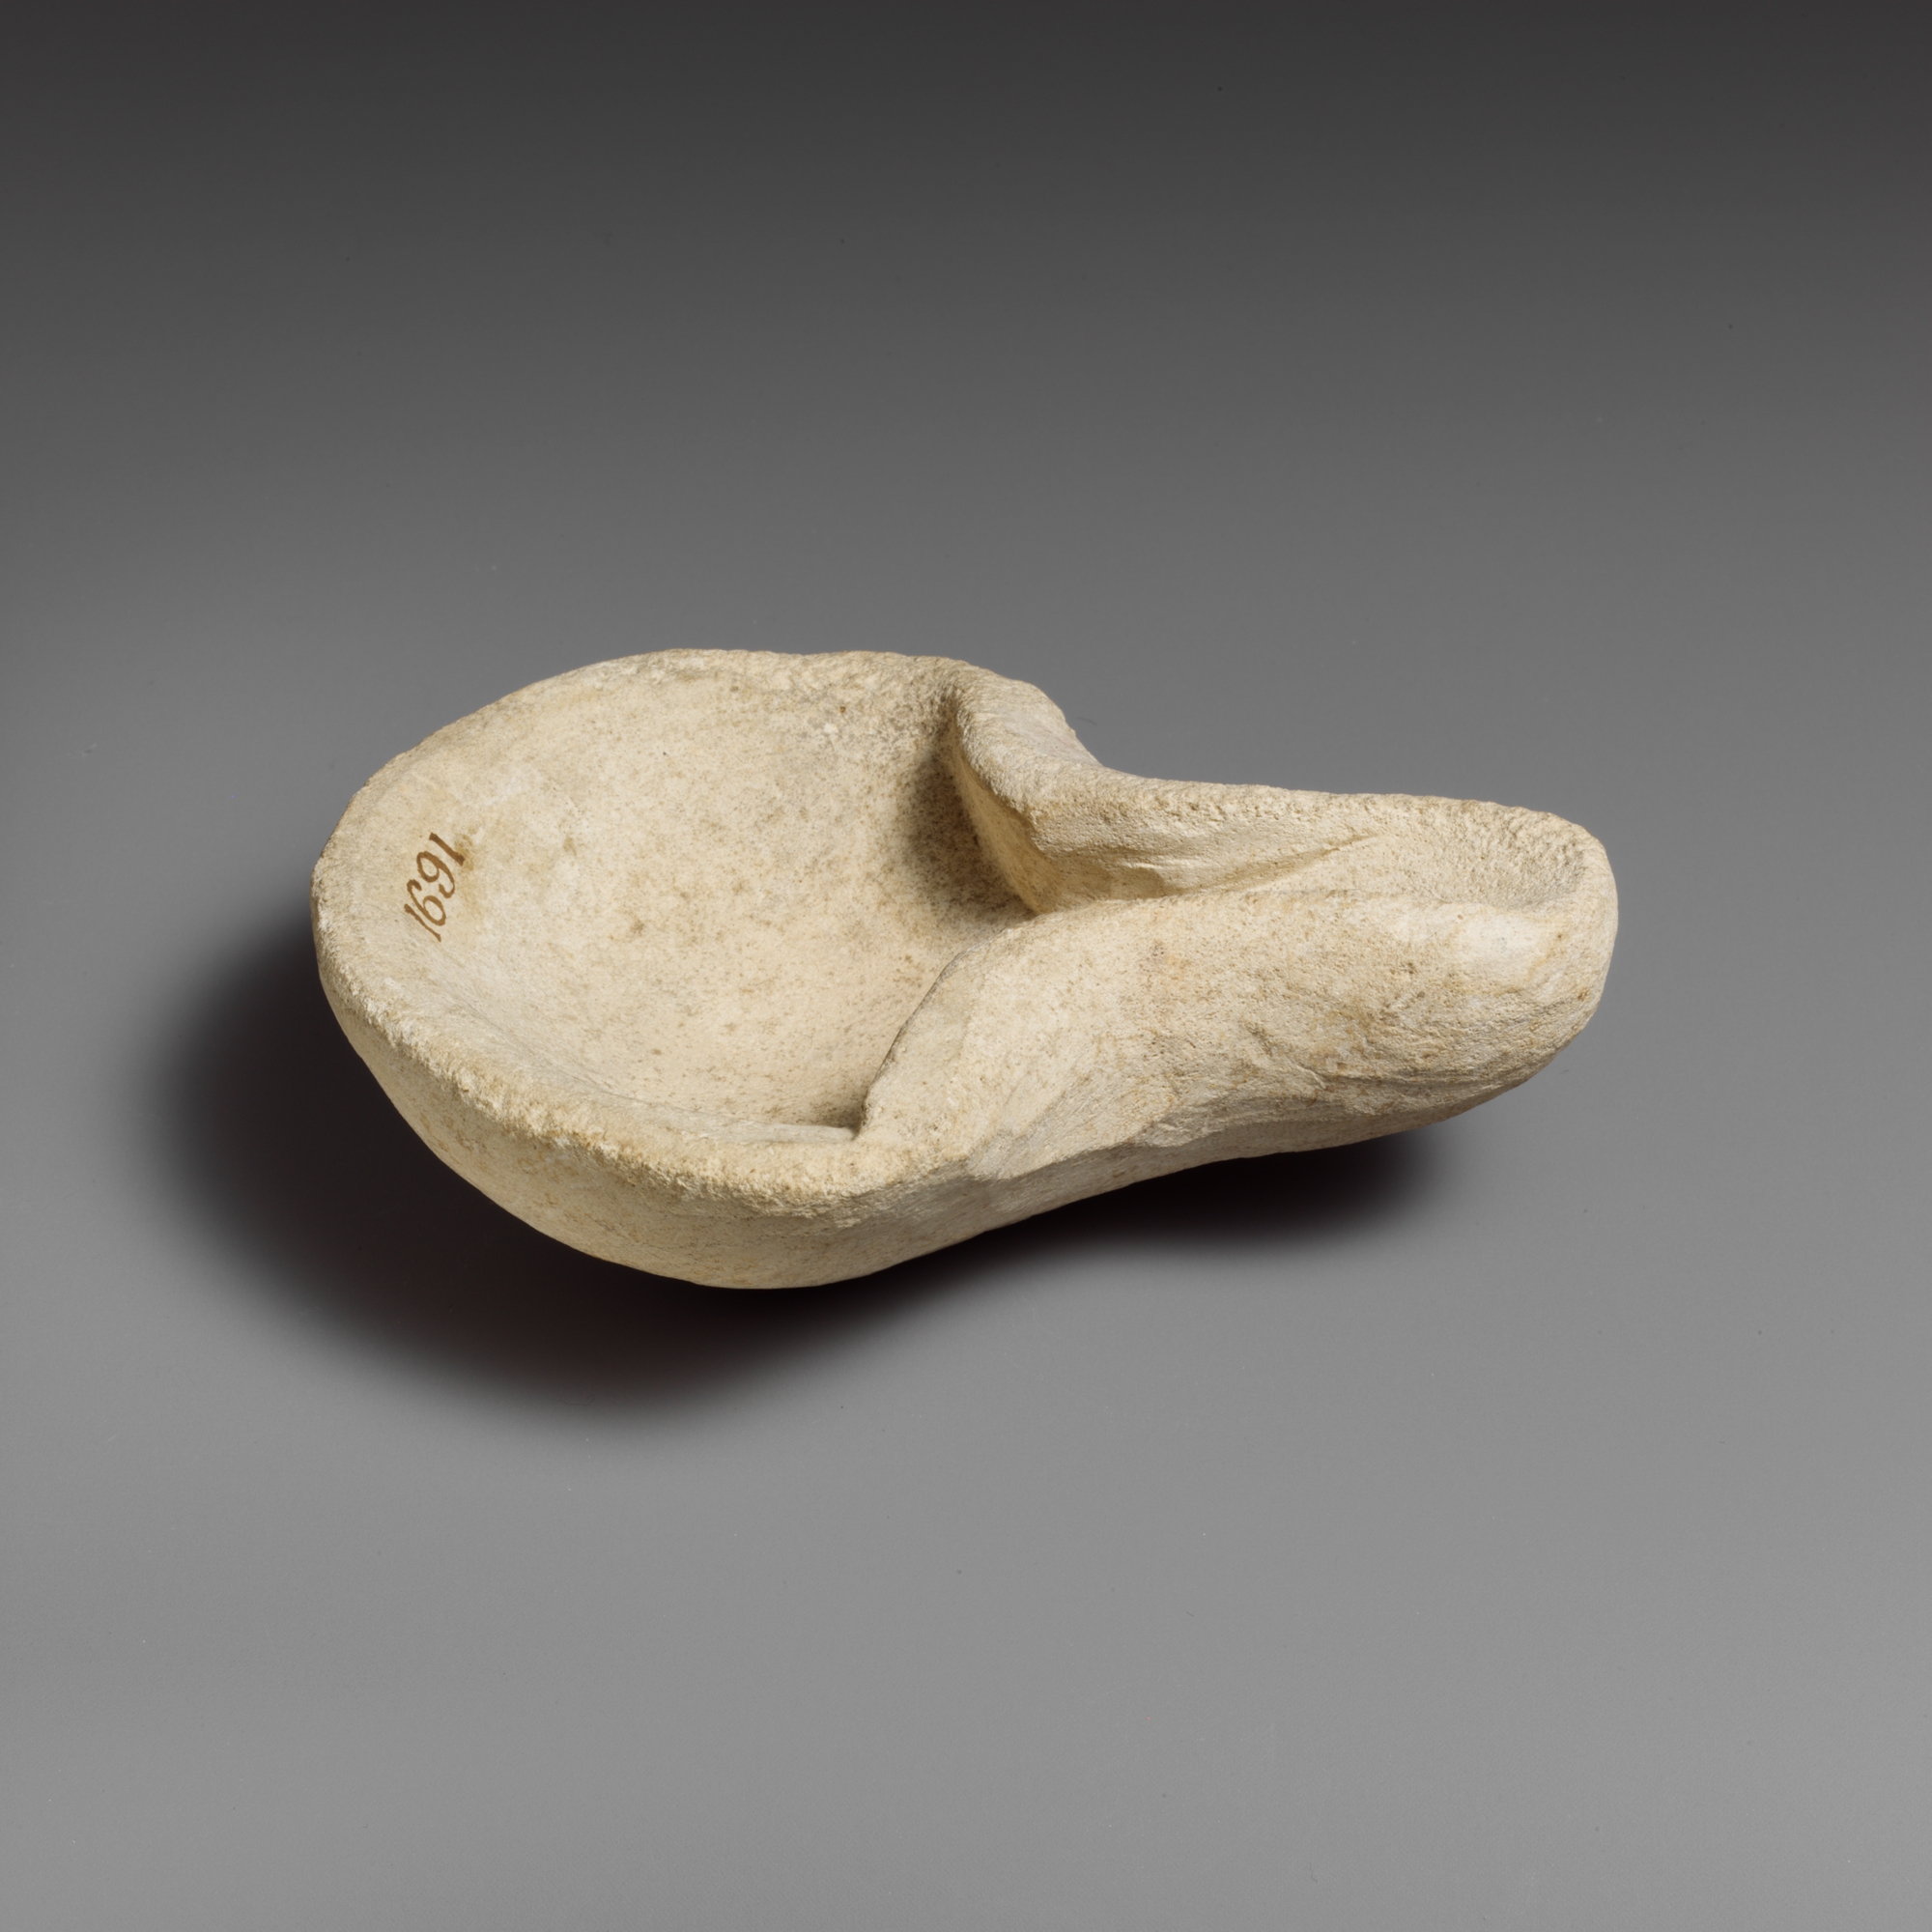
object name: lamp, saucer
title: Limestone saucer lamp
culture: cypriot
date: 500-401 BCE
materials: limestone